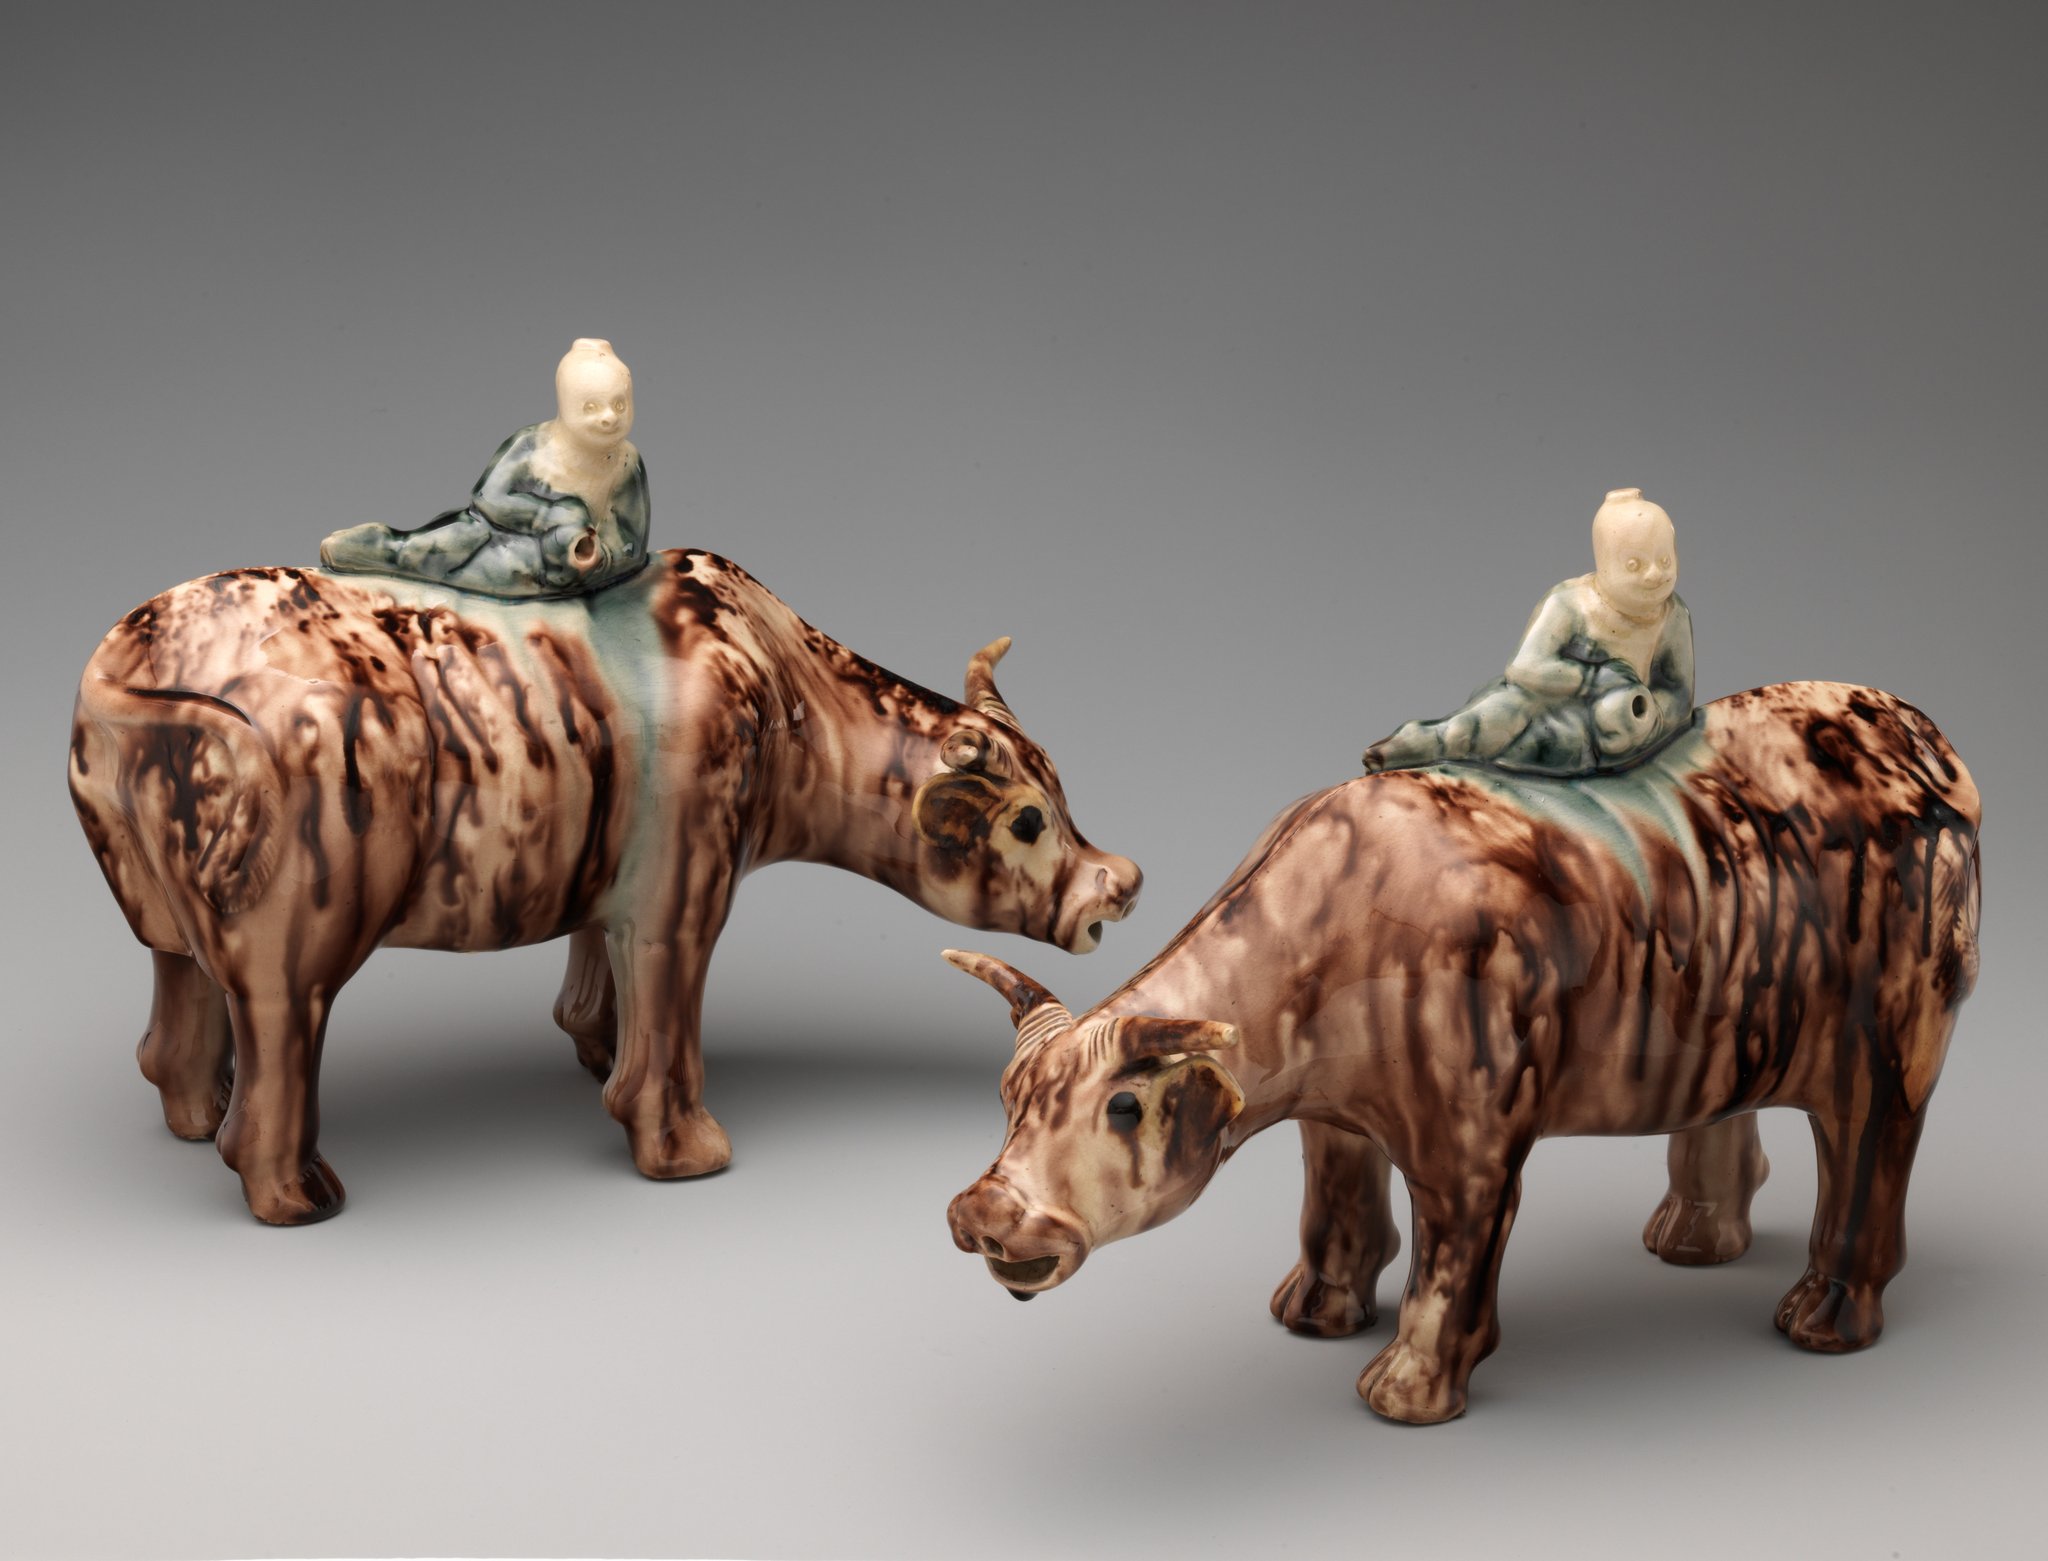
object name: figure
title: Water buffalo and reclining Chinese figure (one of a pair)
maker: whieldon type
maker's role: maker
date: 1760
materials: shell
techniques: glazing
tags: boys,buffalos